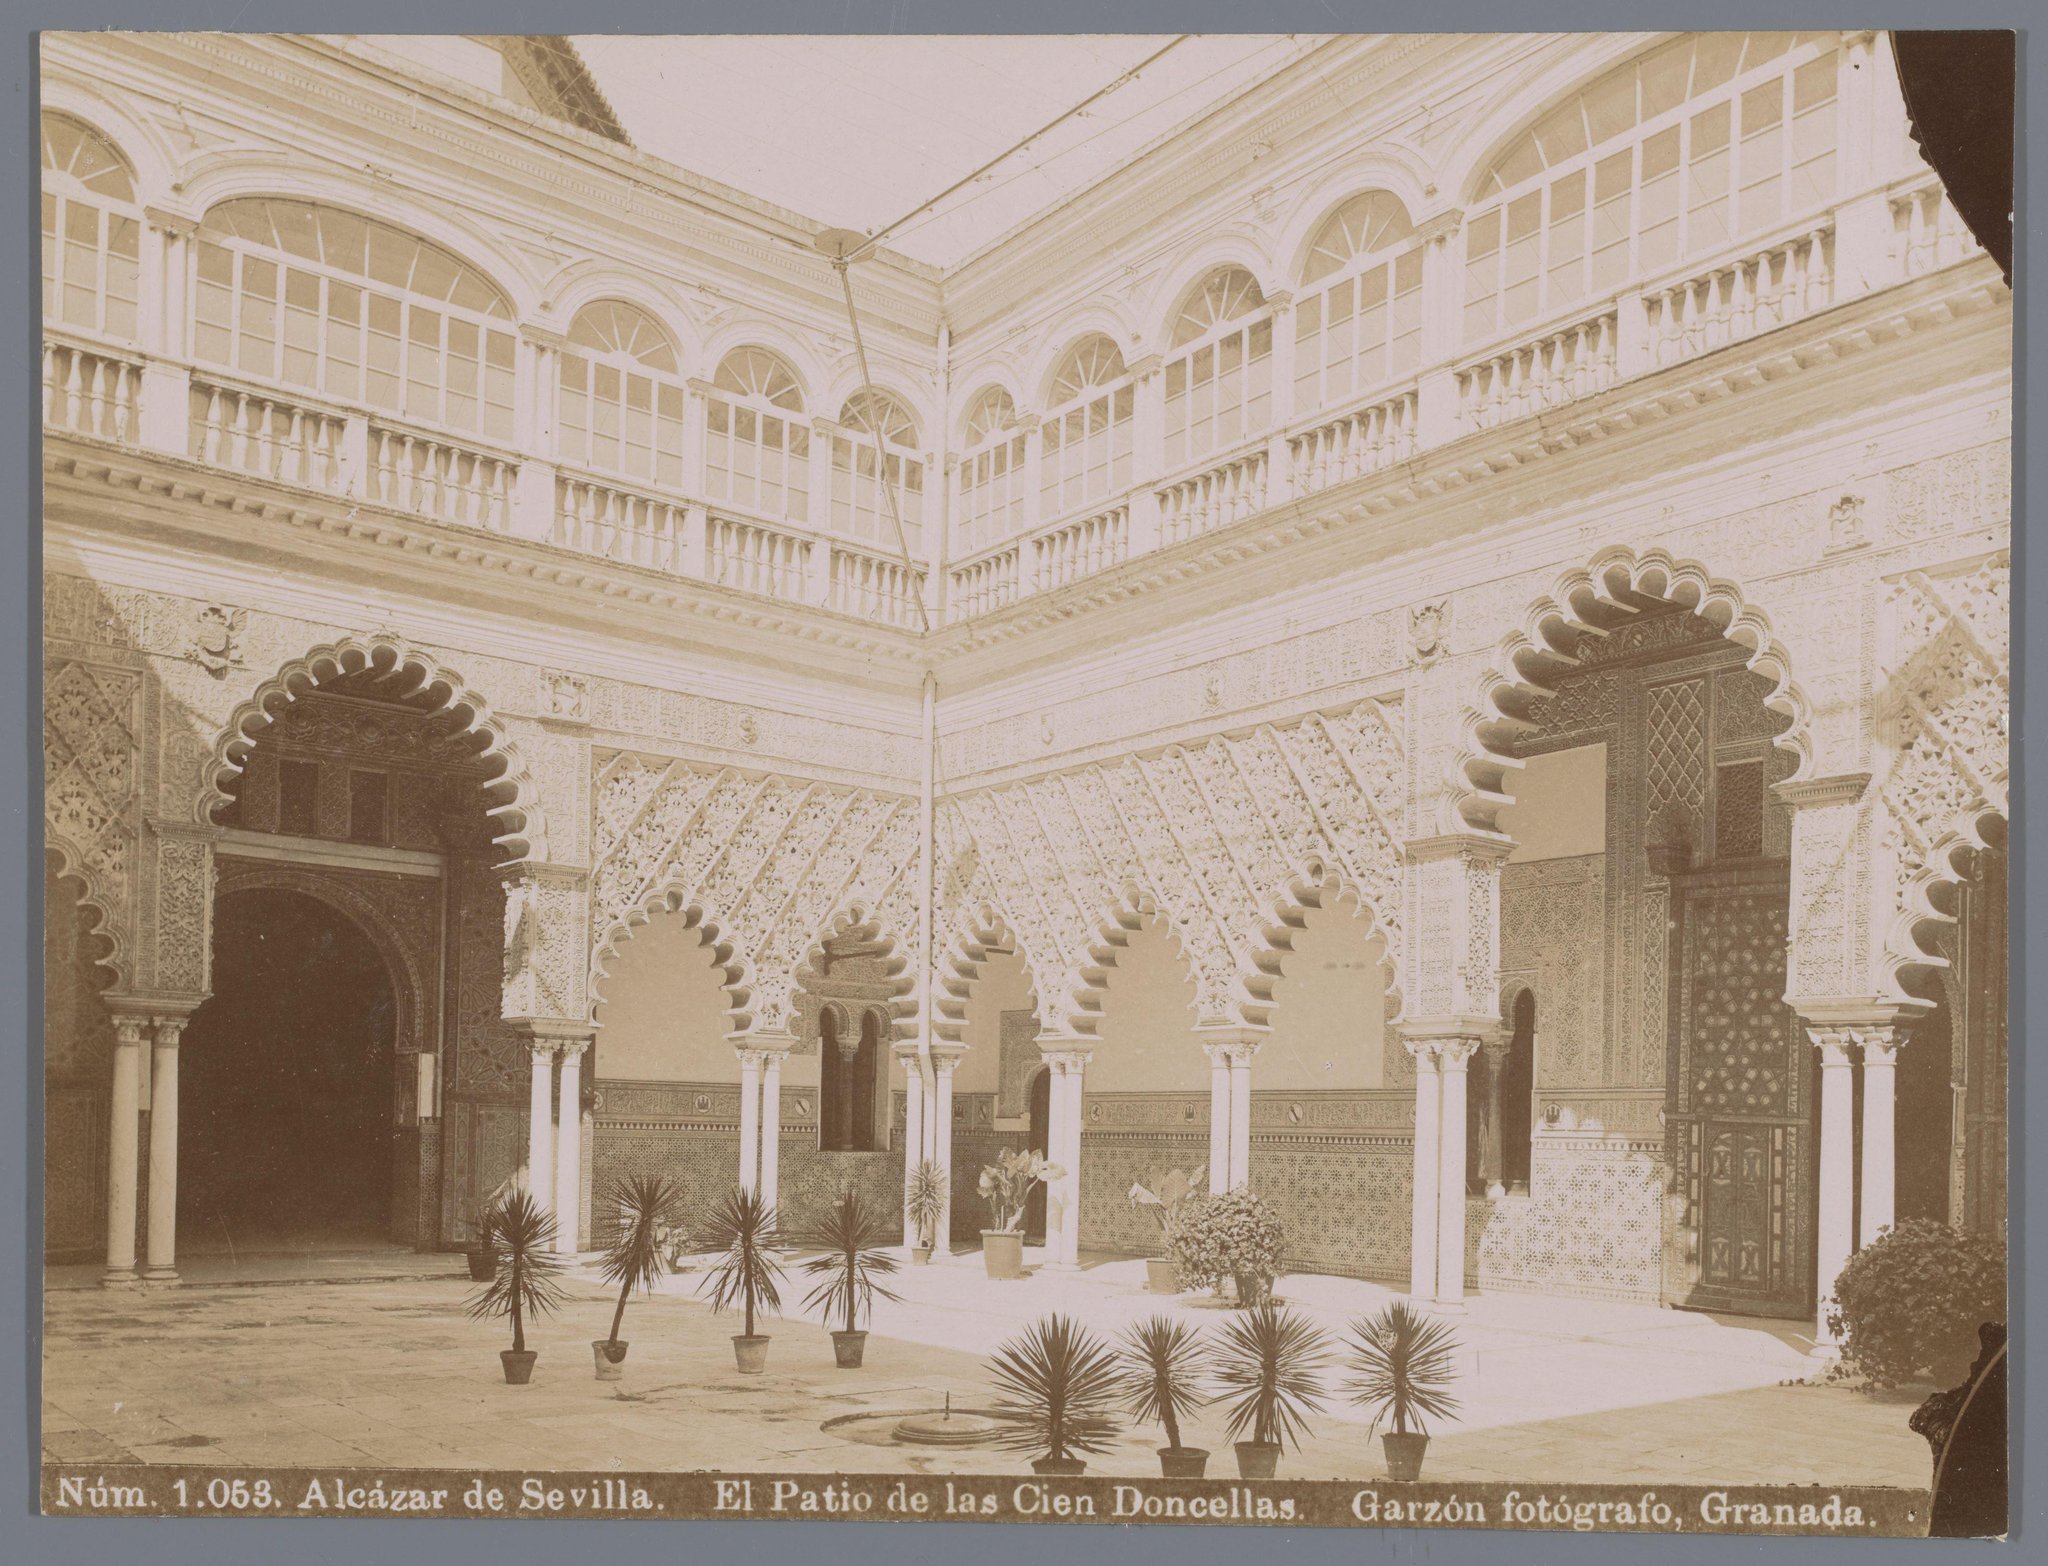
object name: photograph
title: Patio de las Doncellas in het Koninklijk Paleis van Sevilla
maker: rafael garzón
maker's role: publisher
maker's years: 1863-1923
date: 1890-1930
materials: paper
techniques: gelatin silver print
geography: sevilla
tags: inner court of palace or 'hôtel'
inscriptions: number: ‘Núm. 1.053.’